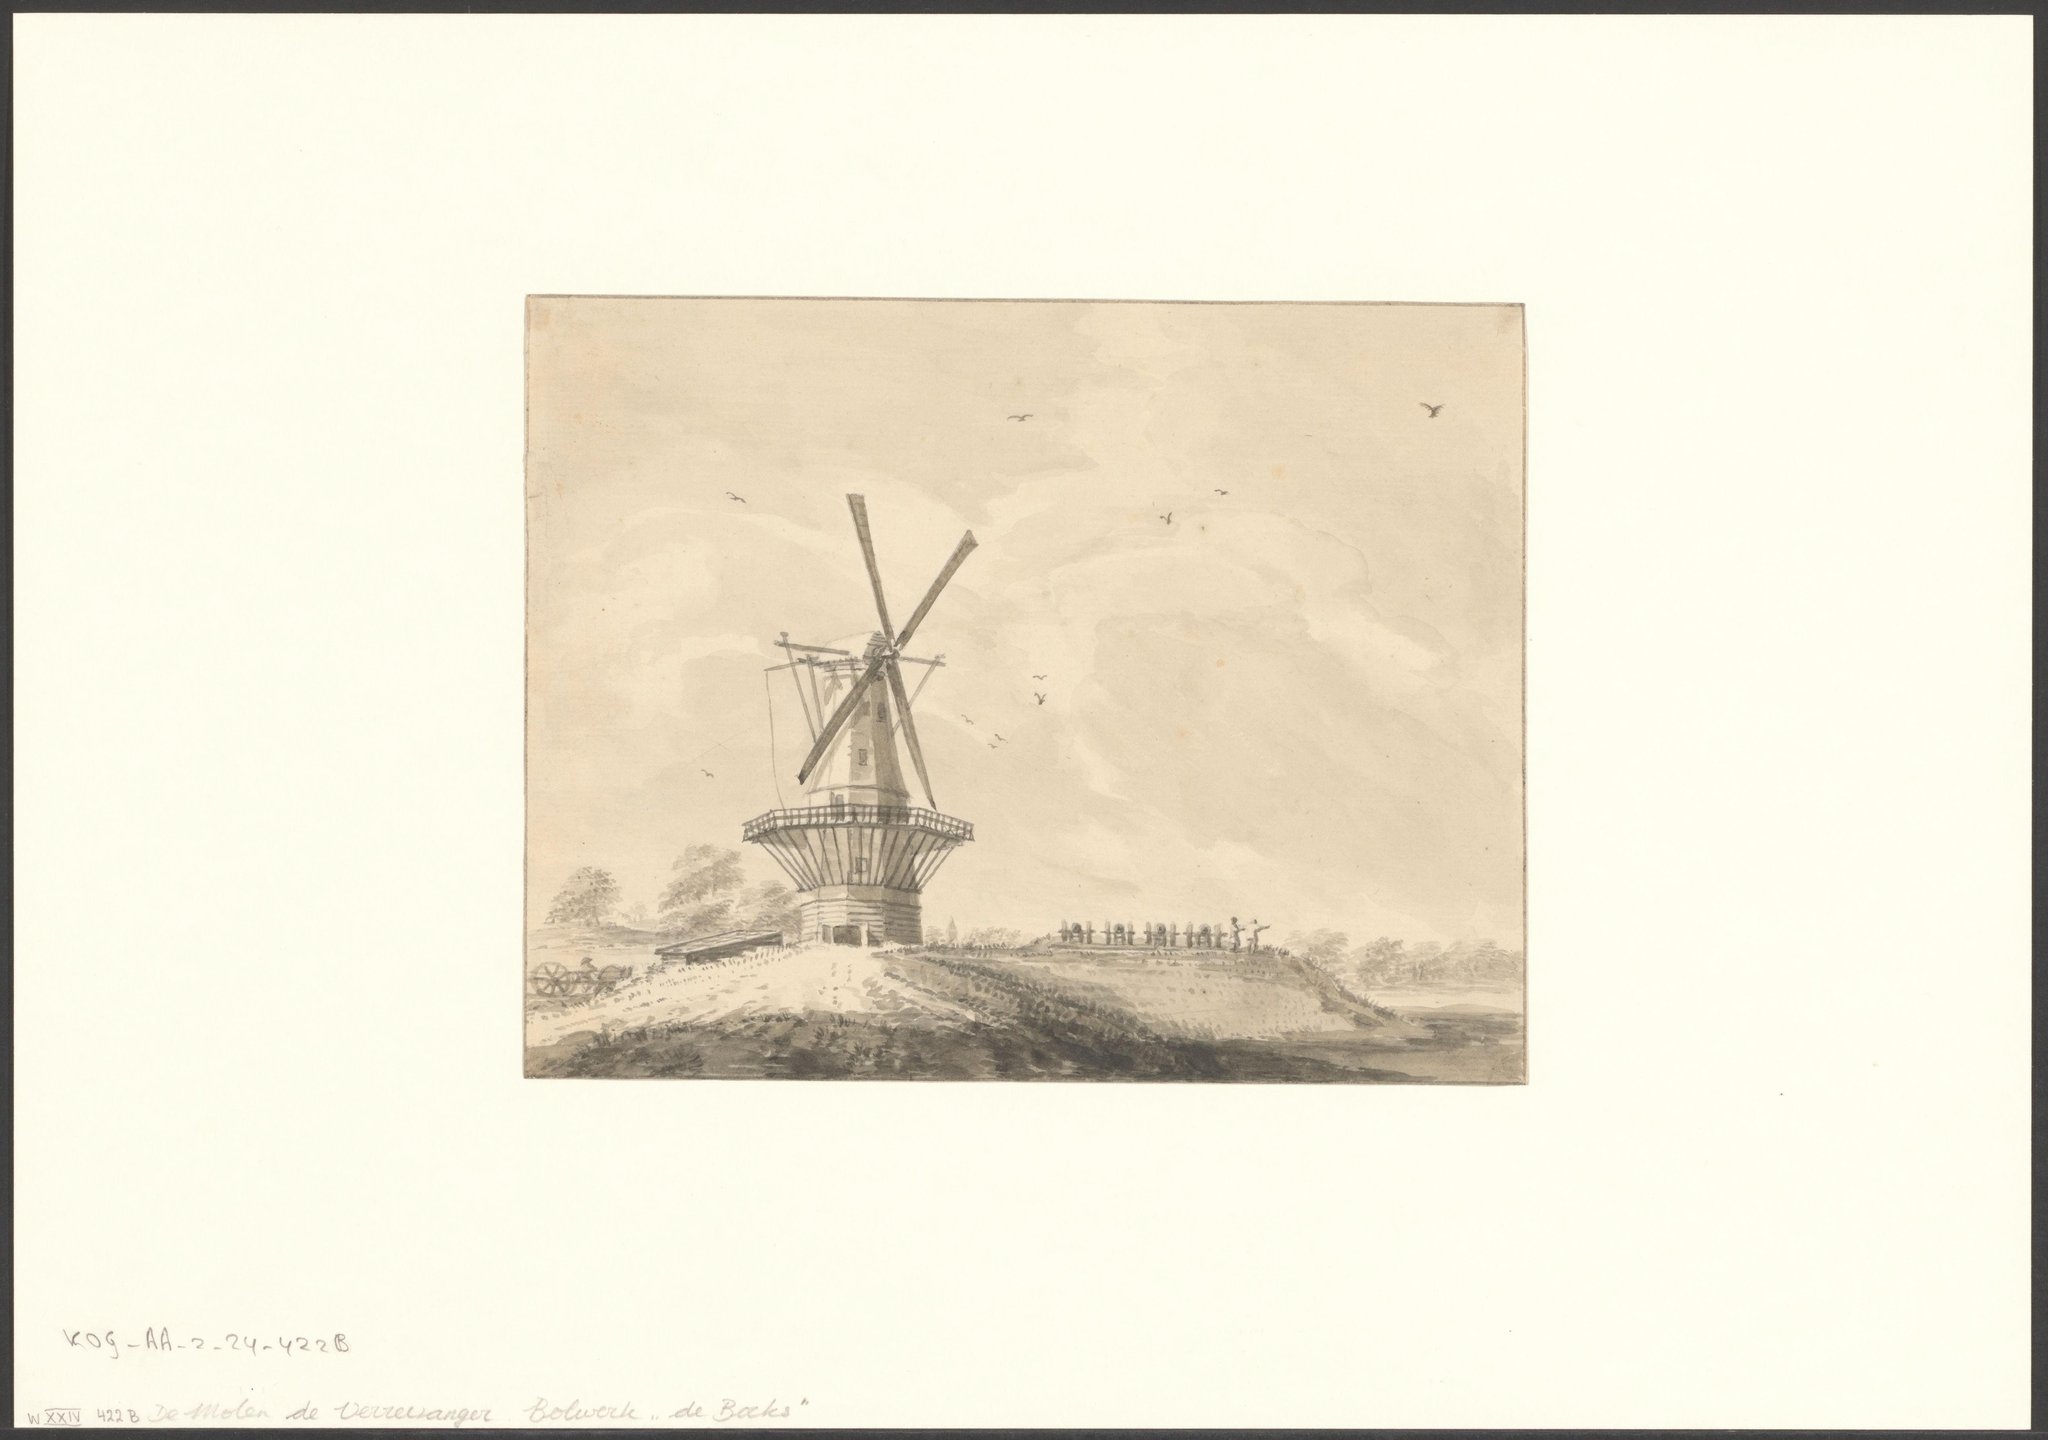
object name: drawing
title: Gezicht op bolwerk De Bocht met molen De Vervanger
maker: bartholomeus barbiers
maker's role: draughtsman, painter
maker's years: 1740-1808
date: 1753-1808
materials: ink, paper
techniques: brush, pen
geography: amsterdam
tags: city-view in general; 'veduta', canal, windmill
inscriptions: collector's mark: Lugt 1557, inscription: ‘de molen de Vervanger. / Bolwerk de Bocht’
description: Tekening binnen de Atlas Van Eck ingedeeld op wijknummer 24.